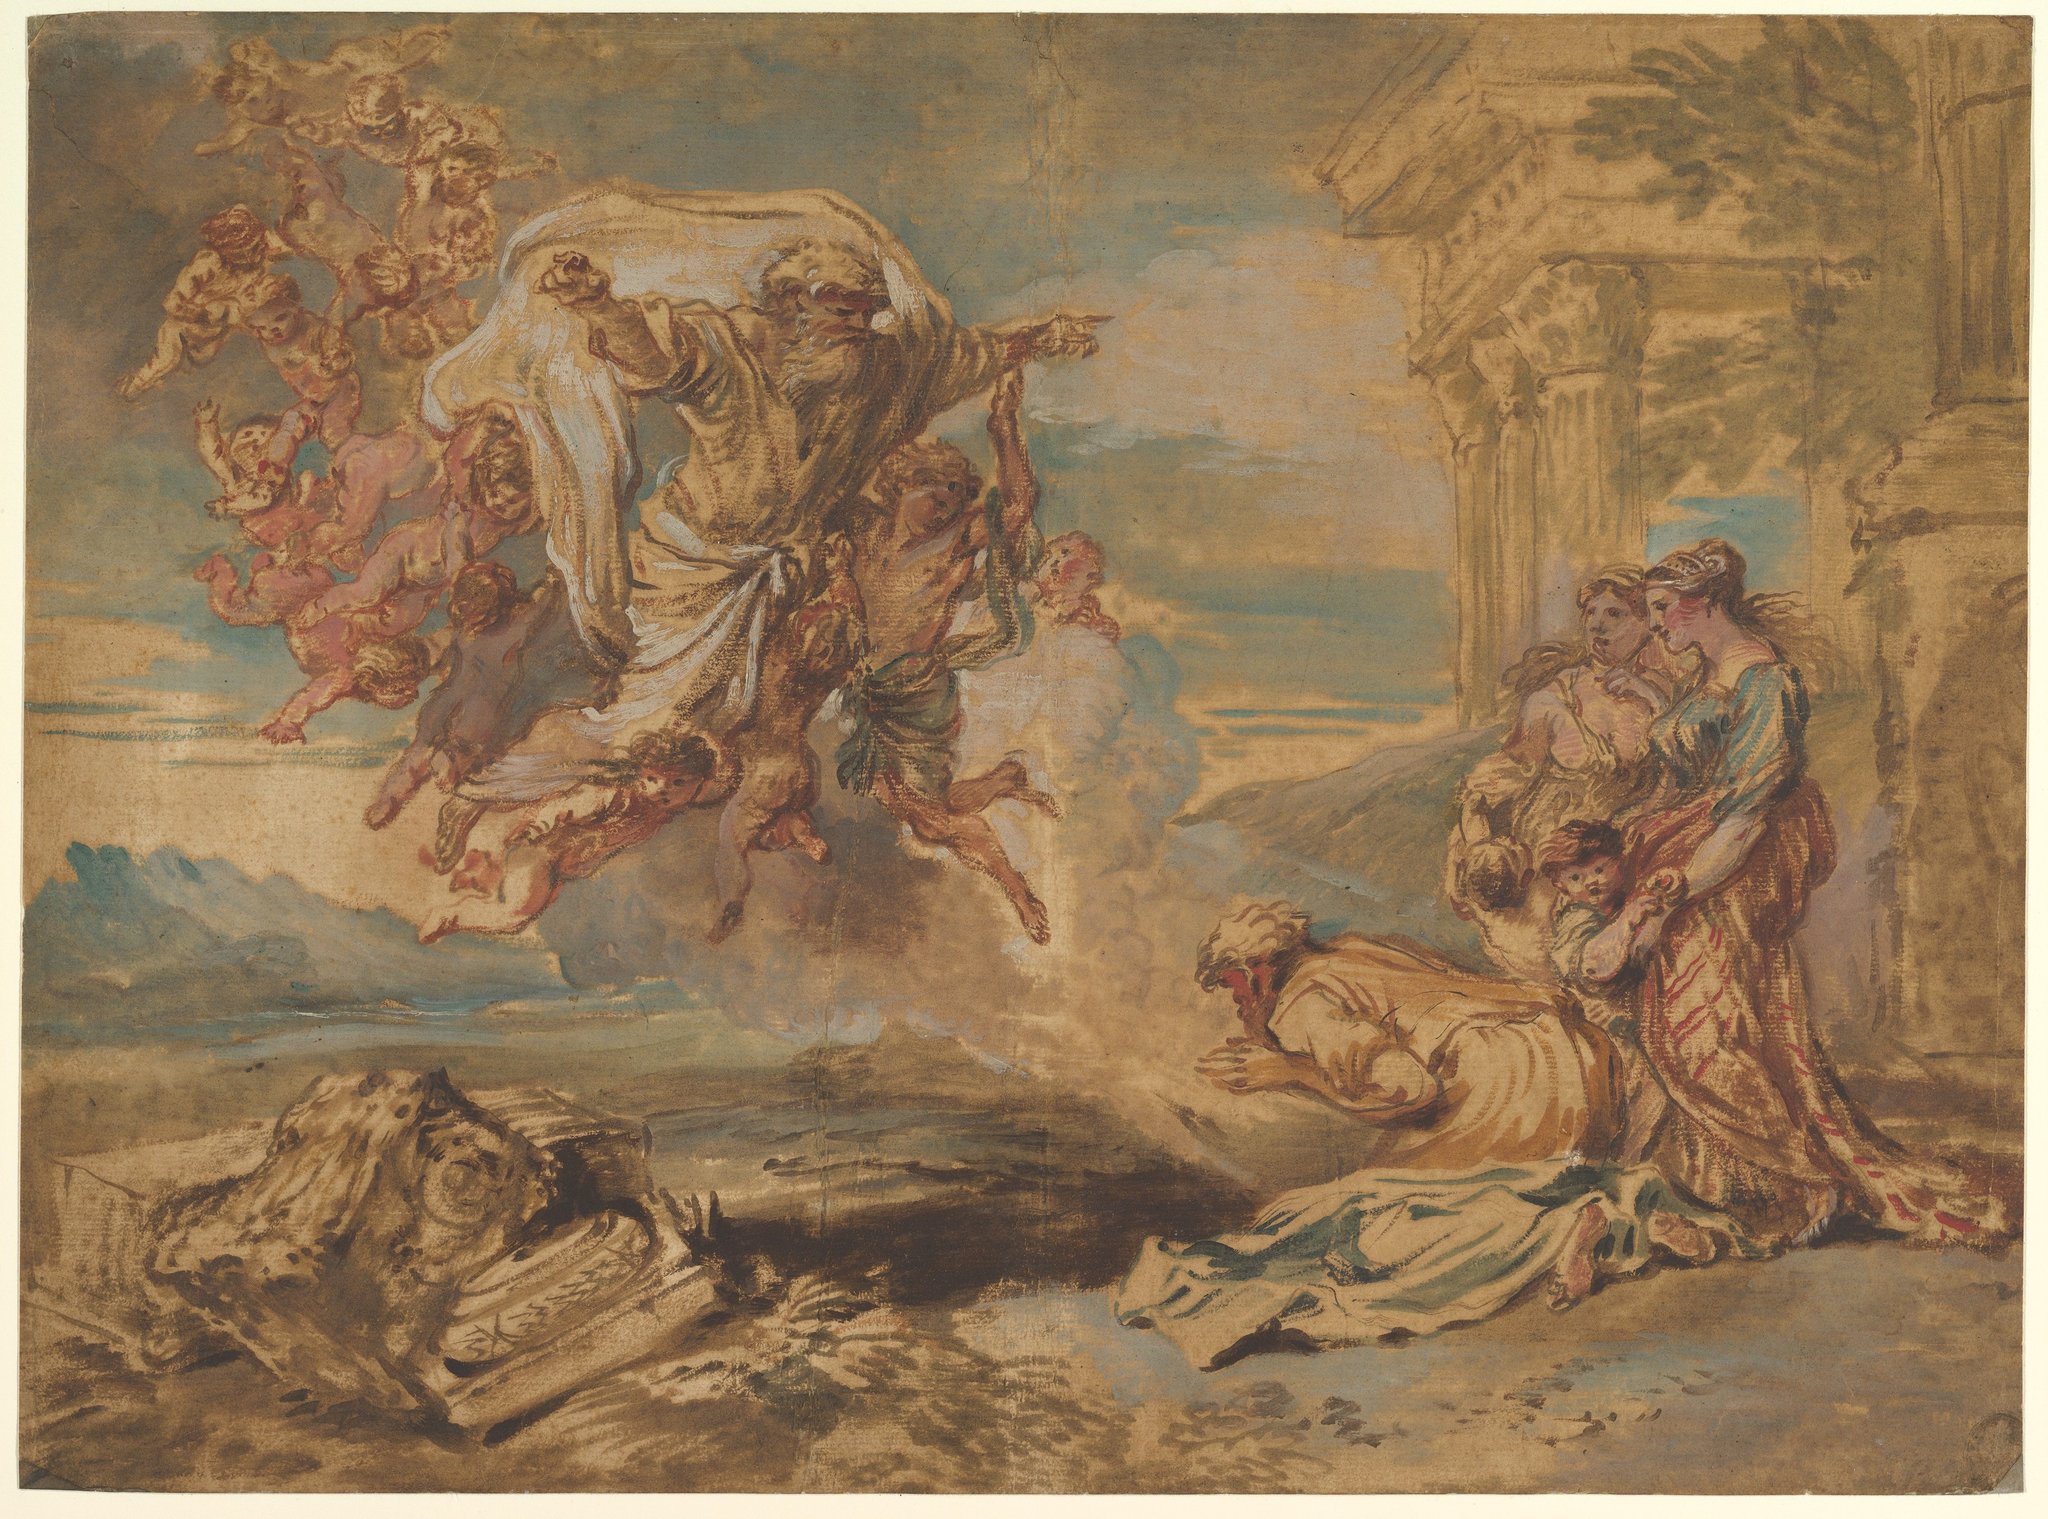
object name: drawing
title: God the Father Appearing to Jacob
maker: giovanni benedetto castiglione (il grechetto)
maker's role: artist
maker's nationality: italian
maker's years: 1609-1664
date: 1635-1645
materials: ink, oil, paper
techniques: brush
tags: men,women,god the father